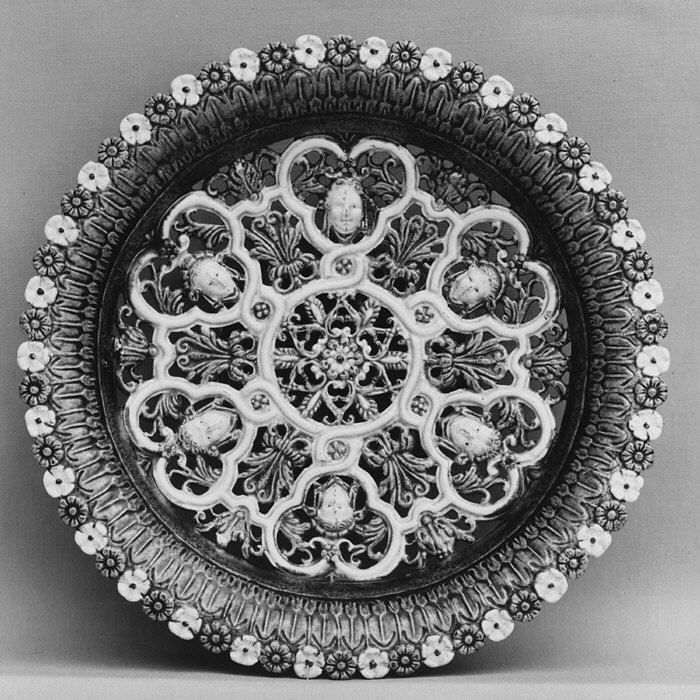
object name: dish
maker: bernard palissy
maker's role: maker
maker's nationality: french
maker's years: 1510-1590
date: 1651-1700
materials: earthenware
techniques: glazing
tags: faces,flowers